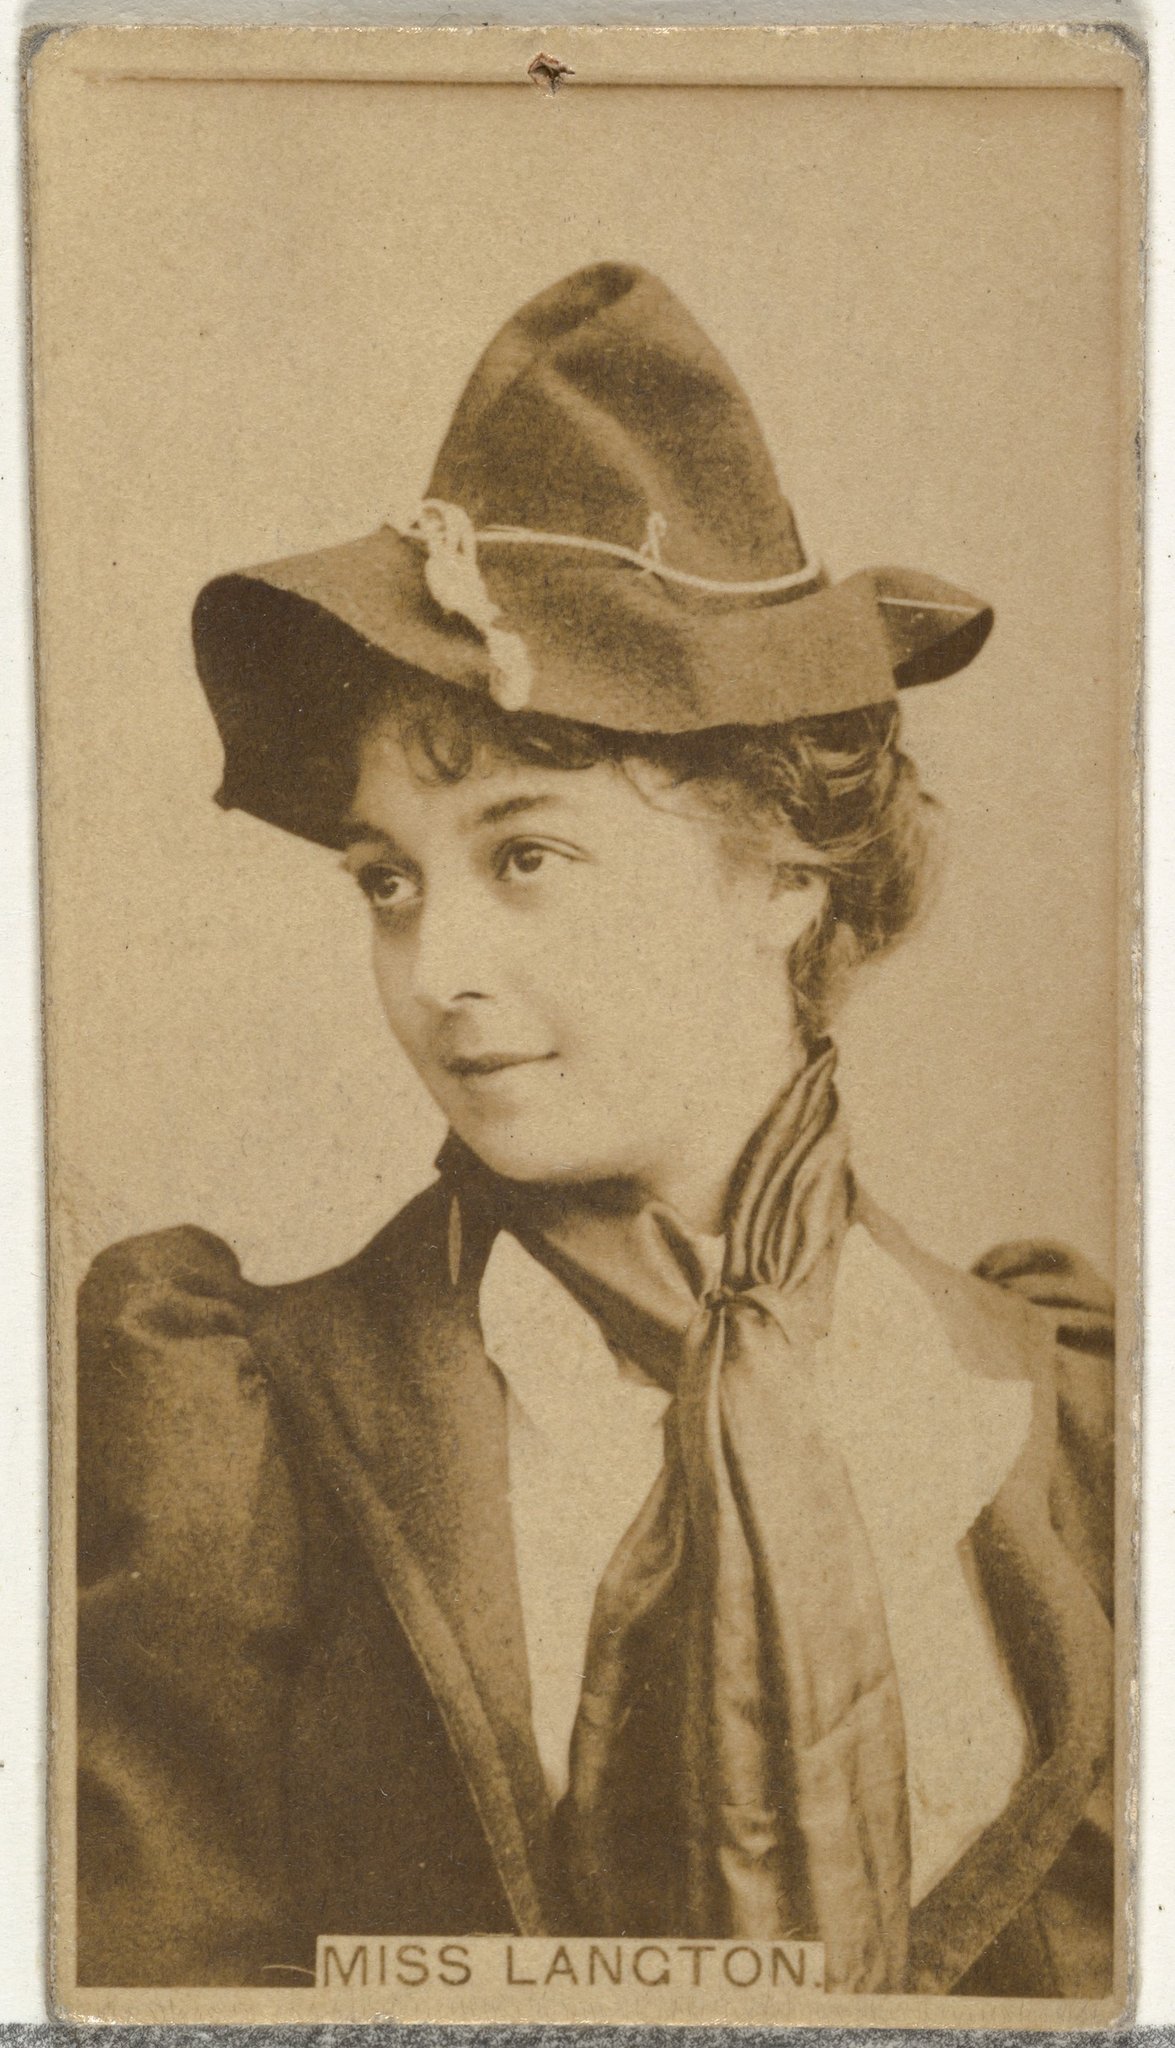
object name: photograph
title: Miss Langton, from the Actors and Actresses series (N145-8) issued by Duke Sons & Co. to promote Duke Cigarettes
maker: w. duke, sons & co.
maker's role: publisher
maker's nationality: american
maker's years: 1870-1920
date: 1891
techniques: albumen silver print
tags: portraits,women,actresses